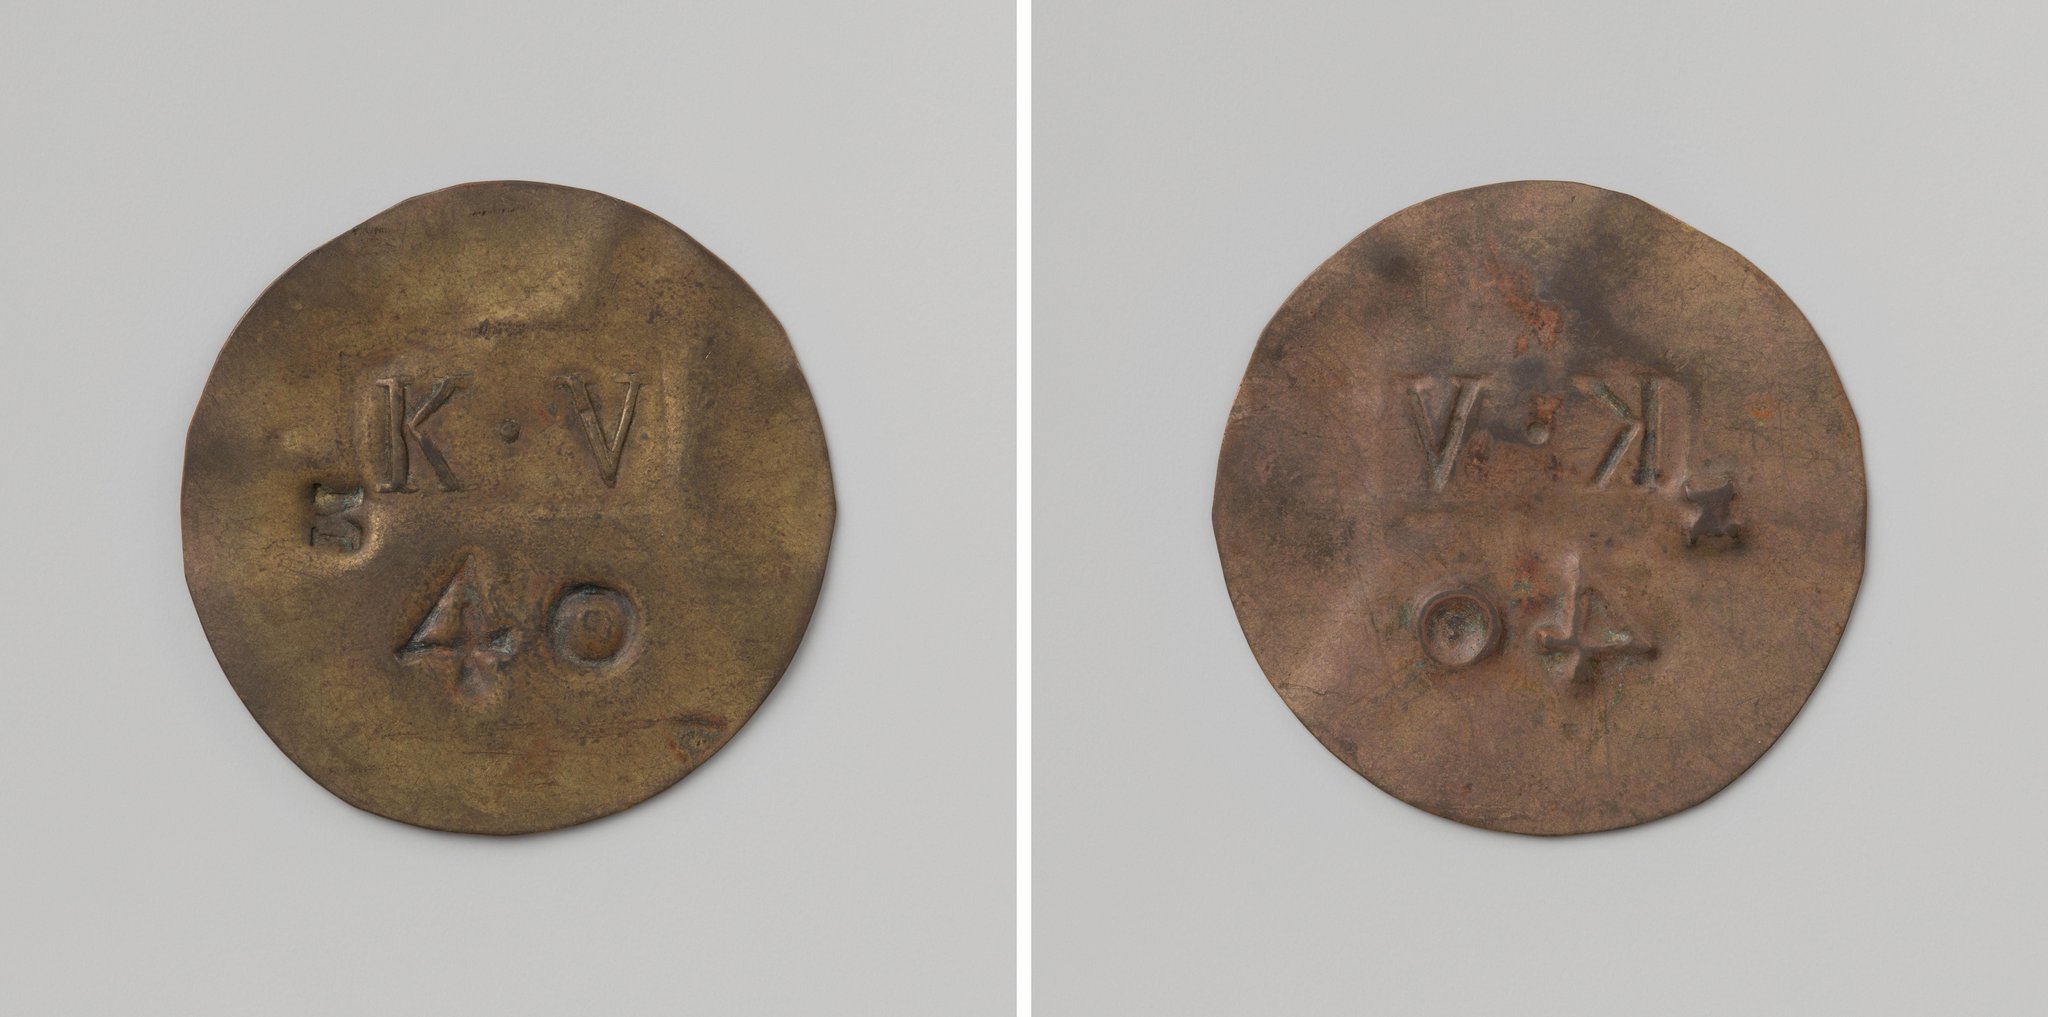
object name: monetary token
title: Kolonie Veenhuizen, huismunt van veertig cent, geslagen op last van de Maatschappij van Weldadigheid ter waarde van 40 cent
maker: Anonymous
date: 1818-1859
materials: brass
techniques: striking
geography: netherlands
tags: maatschappij van weldadigheid, veenhuizen